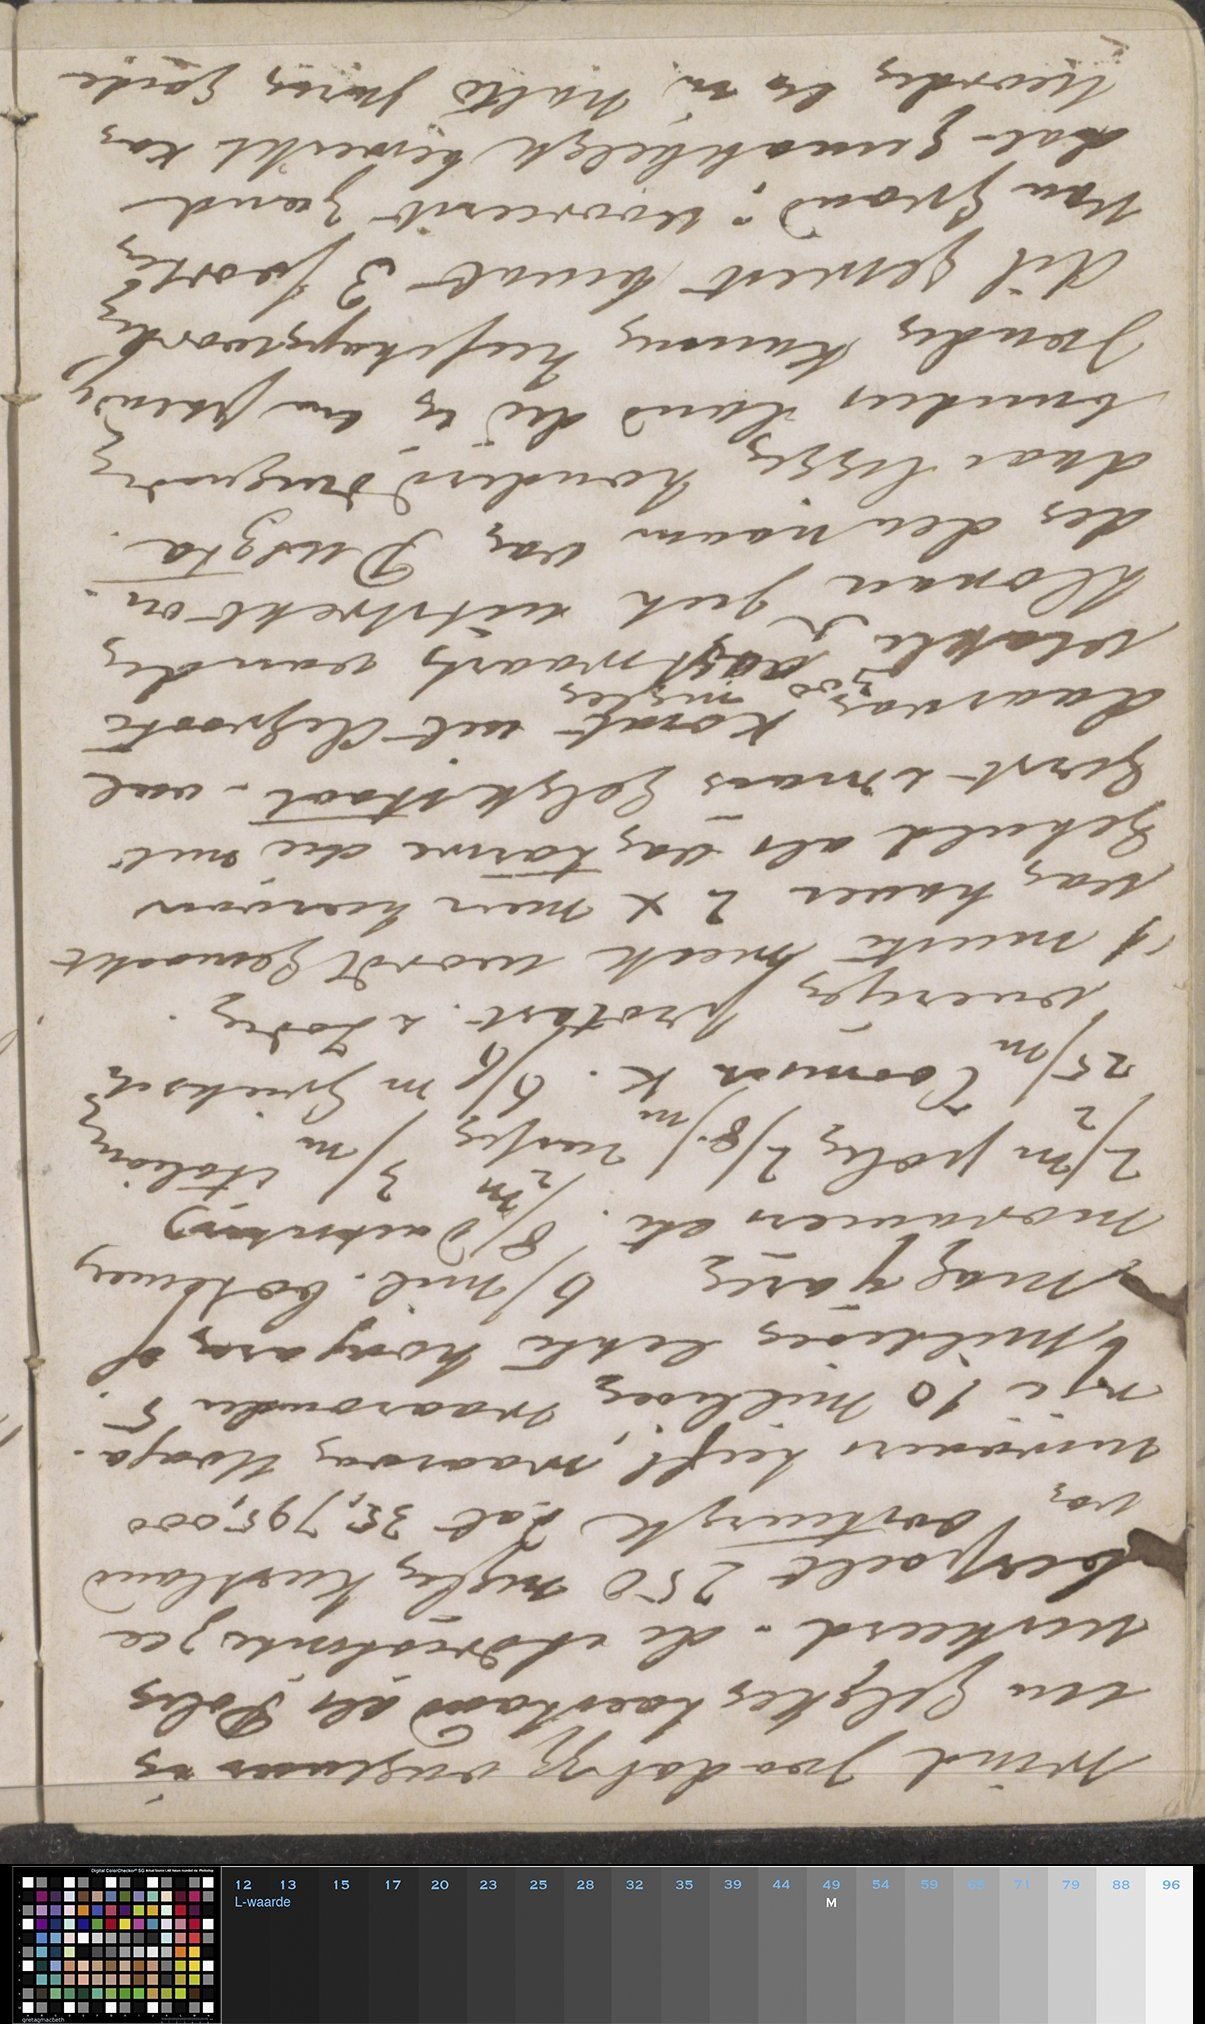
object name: sketchbook leaf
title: Deel van een artikel over Hongarije gekopieerd uit de 'Quarterly Review'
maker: johannes tavenraat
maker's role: draughtsman, painter, print maker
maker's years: 1809-1881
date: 1862-1864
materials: ink, paper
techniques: pen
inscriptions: annotation: ‘[...]’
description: Blad 55 recto uit een schetsboek met 65 bladen.